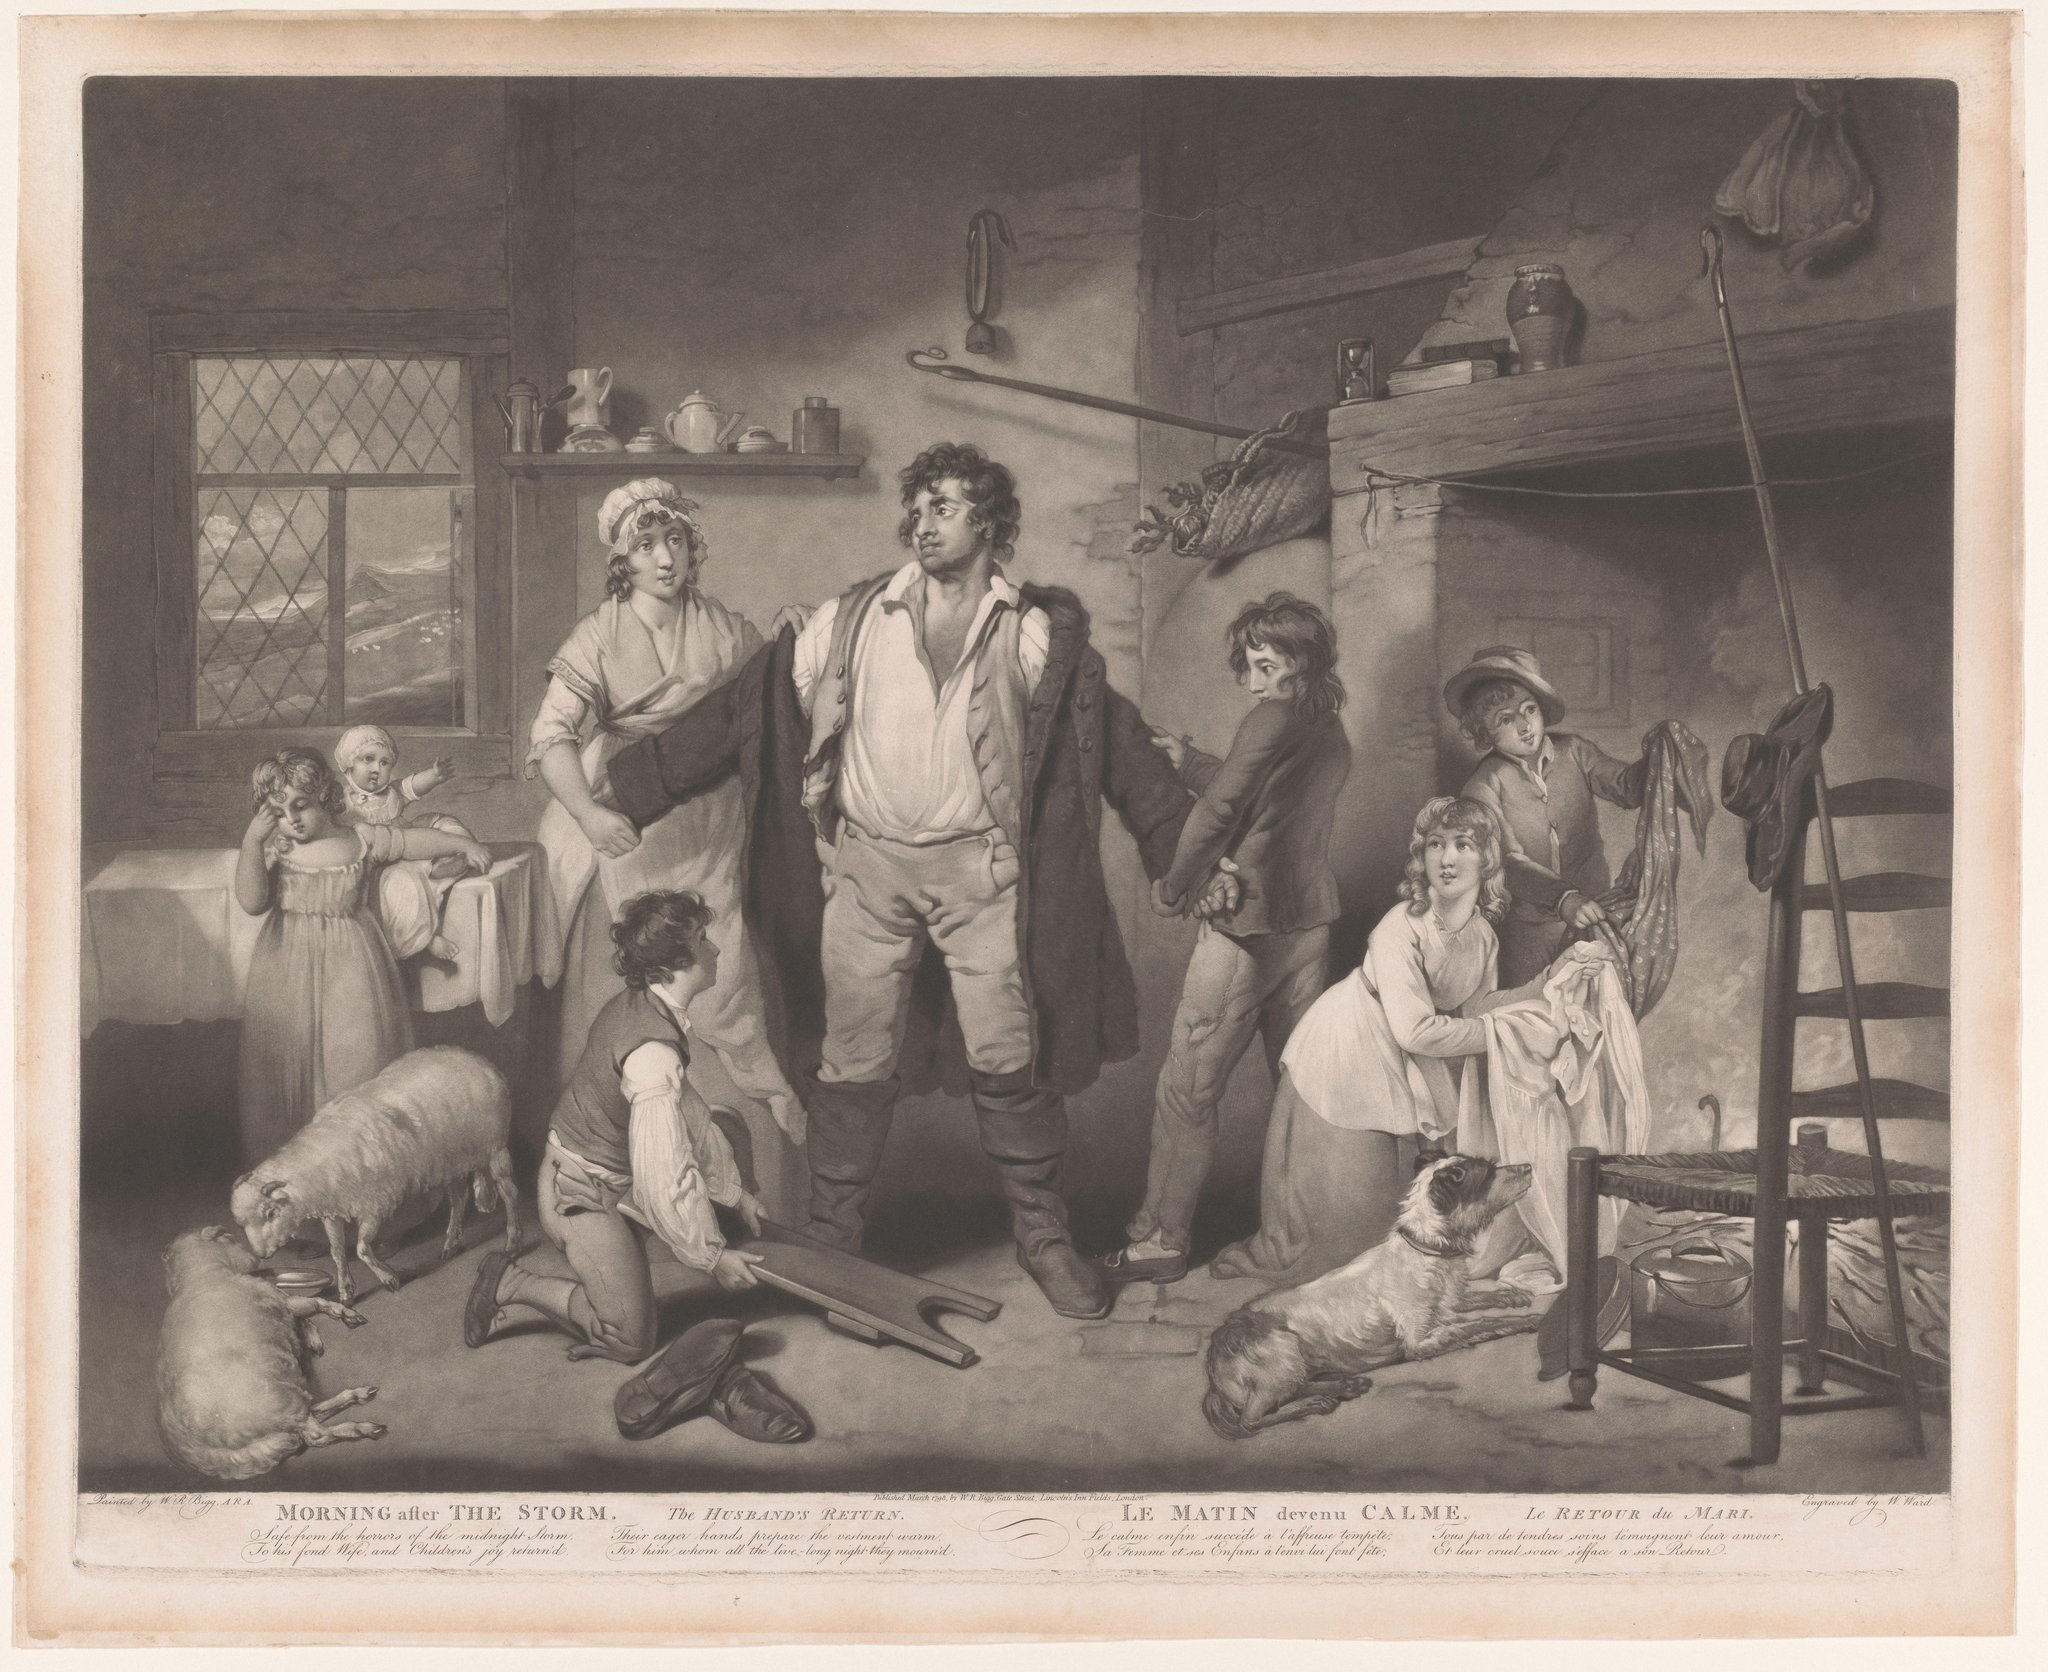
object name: print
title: Morning after the Storm, the husband's return / Le Matin devenue Calme, le retour du mari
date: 1798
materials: paper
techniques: engraving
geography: london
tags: arrival and return ~ travelling, family life at home, storm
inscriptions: collector's mark: Lugt 2228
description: Tekst in het Engels en Frans in de ondermarge.